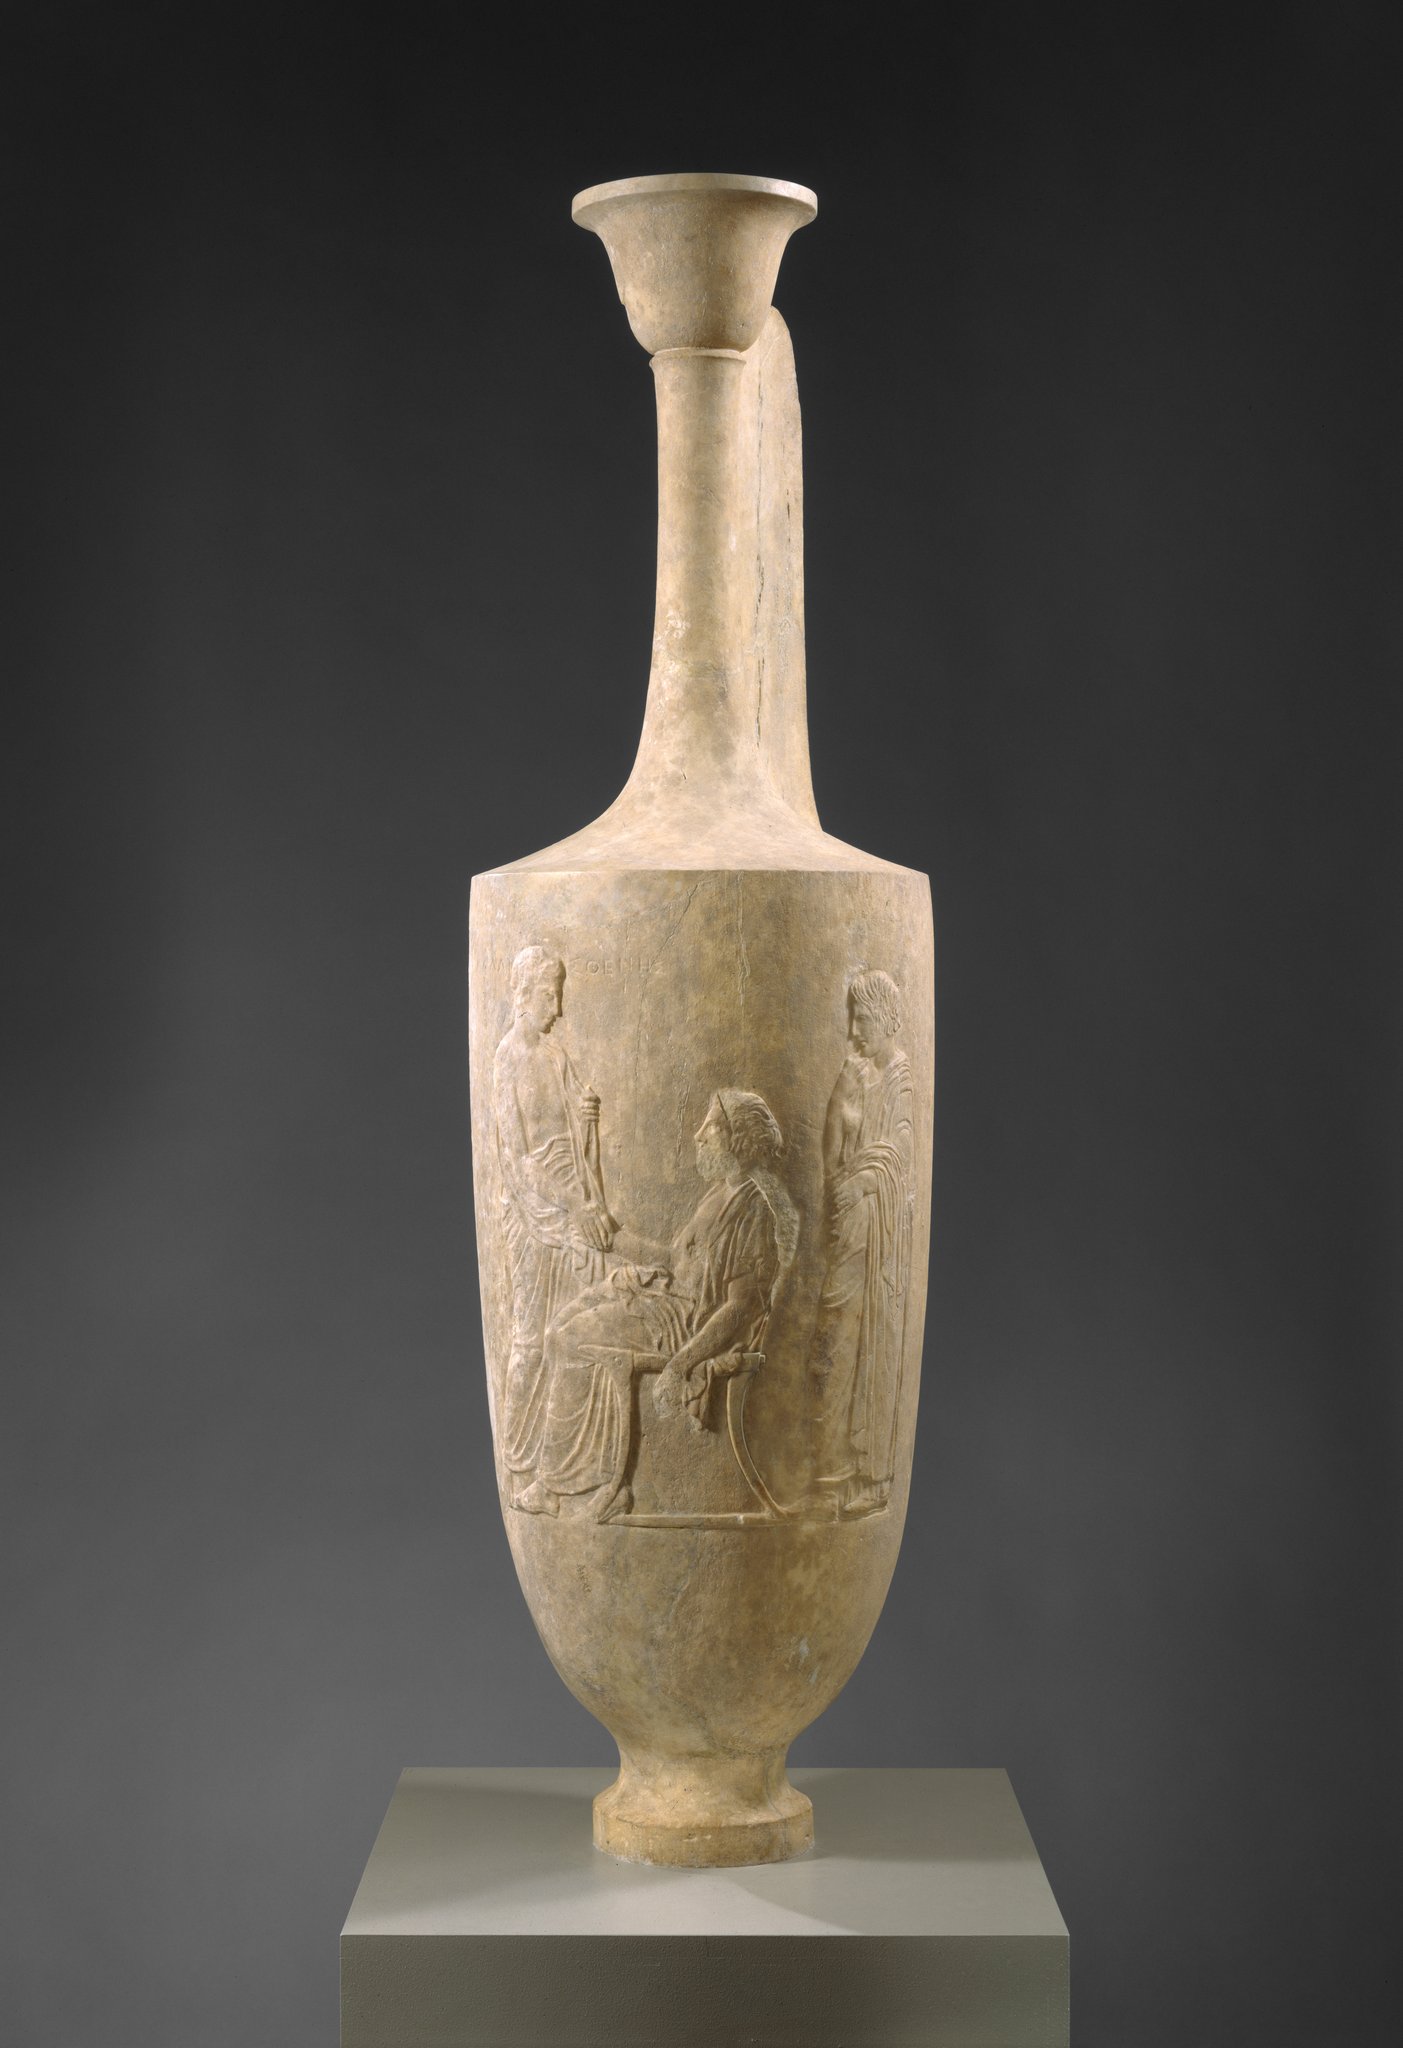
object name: lekythos, funerary, of kallisthenes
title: Marble funerary lekythos of Kallisthenes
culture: greek, attic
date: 400-390 BCE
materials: marble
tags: men,women